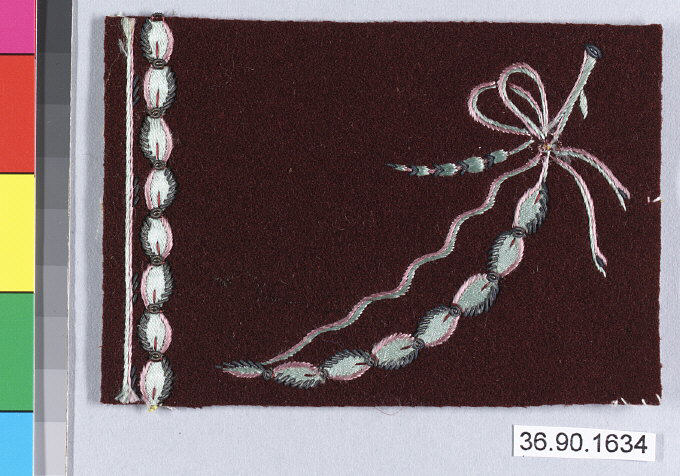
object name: sample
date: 1801-1833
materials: felt, metal thread, silk